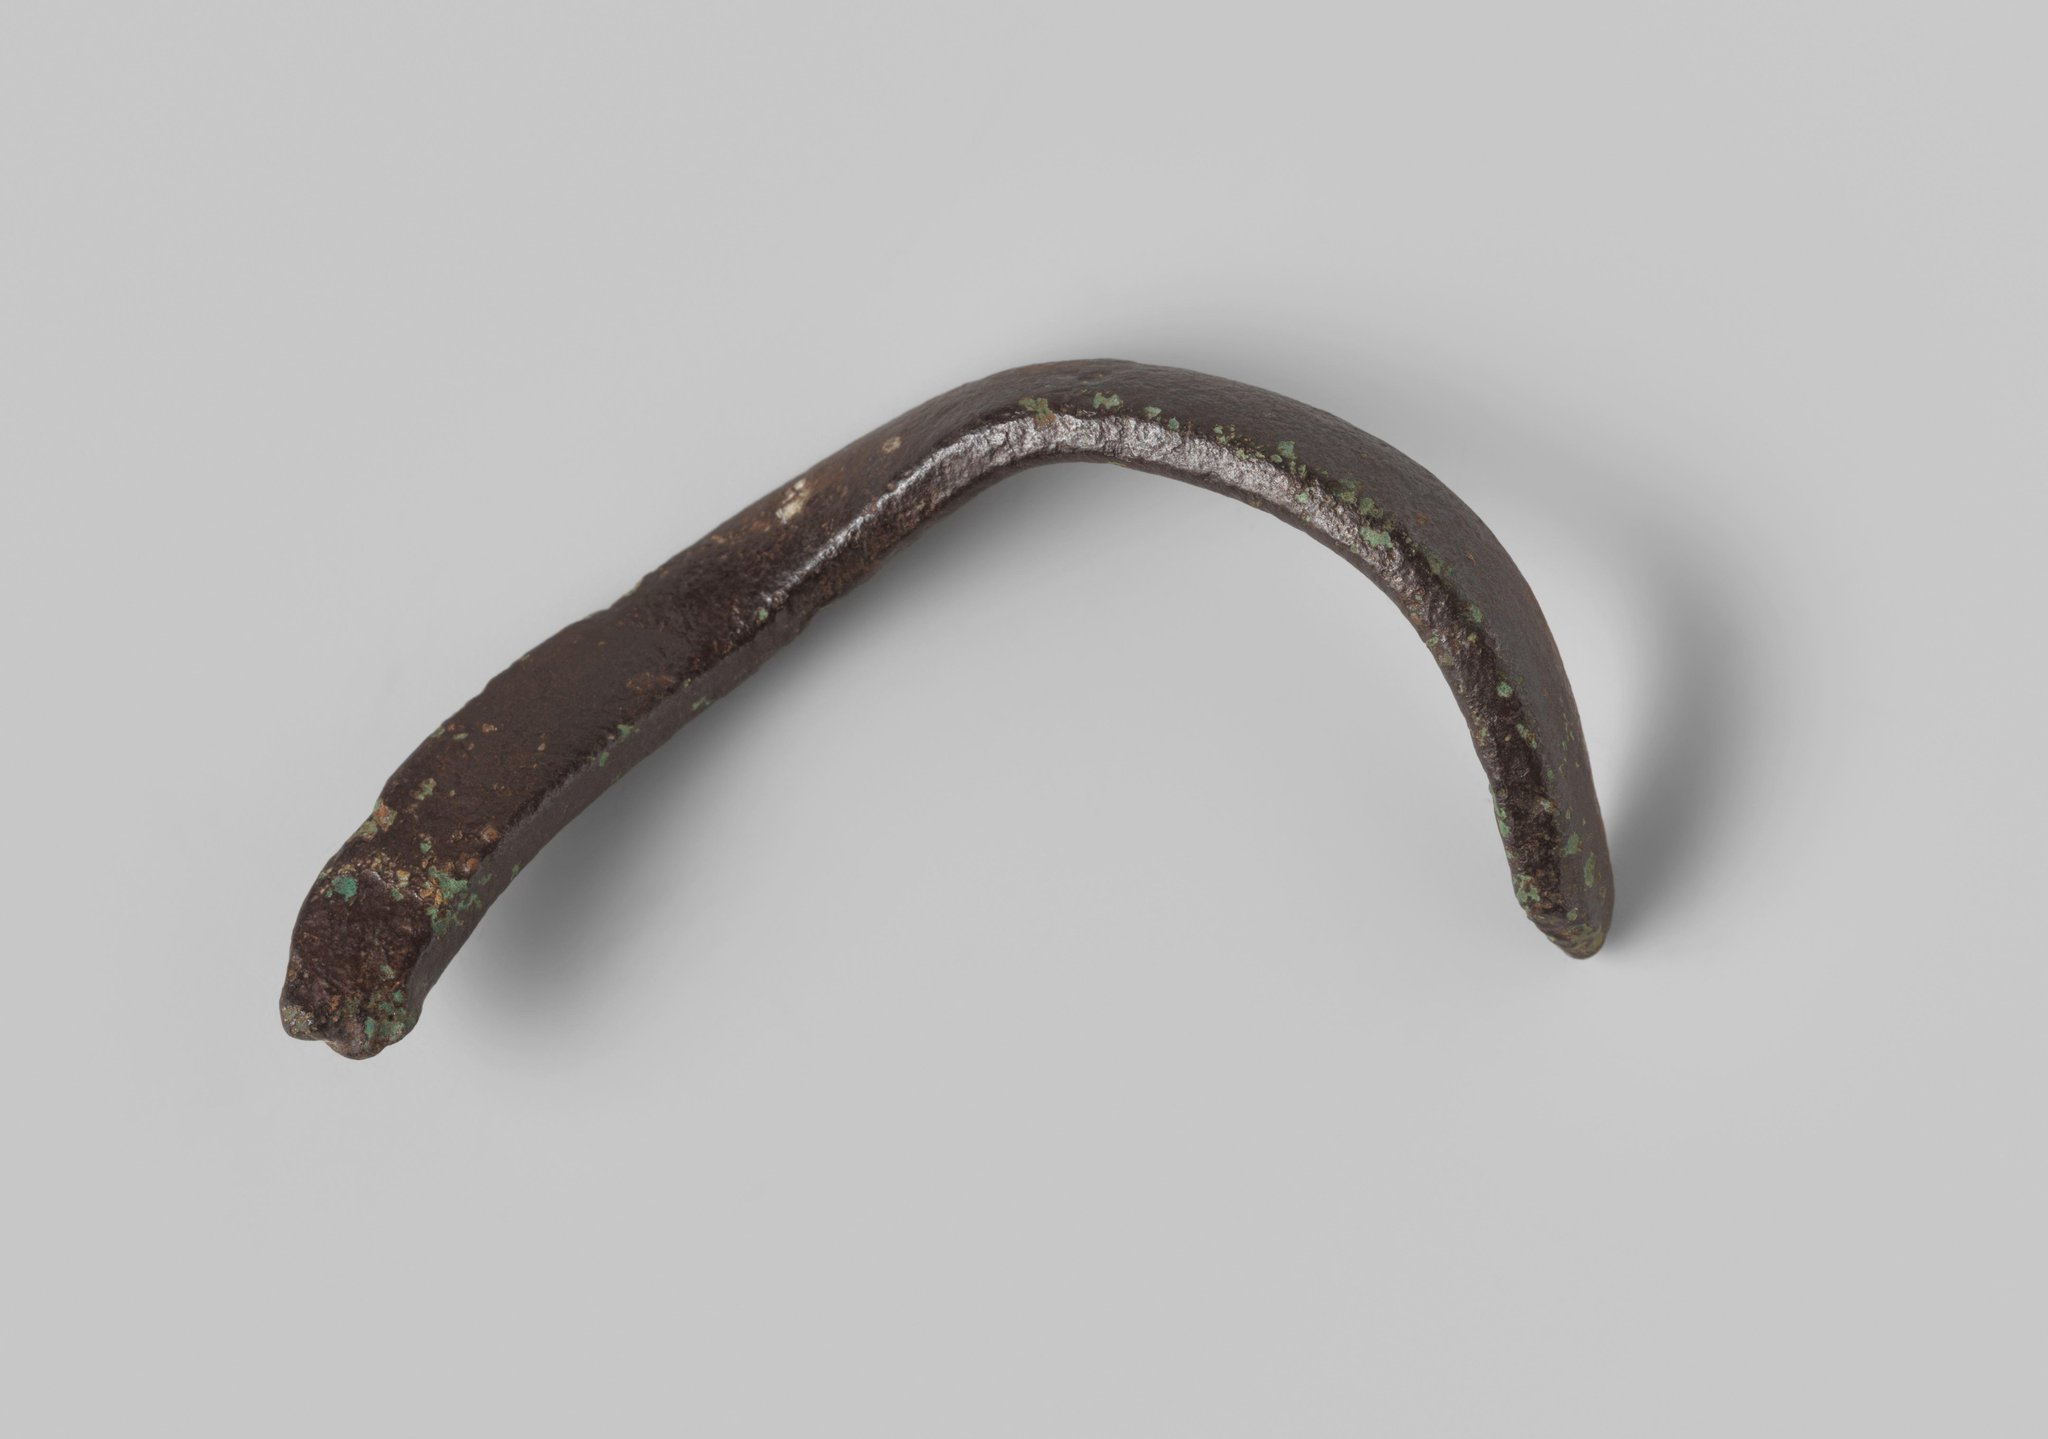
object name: belt buckle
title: Fragment riemgesp uit het wrak van de Oost-Indiëvaarder Hollandia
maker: Anonymous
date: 1700-1743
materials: copper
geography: netherlands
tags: verenigde oostindische compagnie, hollandia (schip), annet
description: Rectangular, fragm of ring, eroded, broken, id. NG 1980-27H2852, belt buckle.